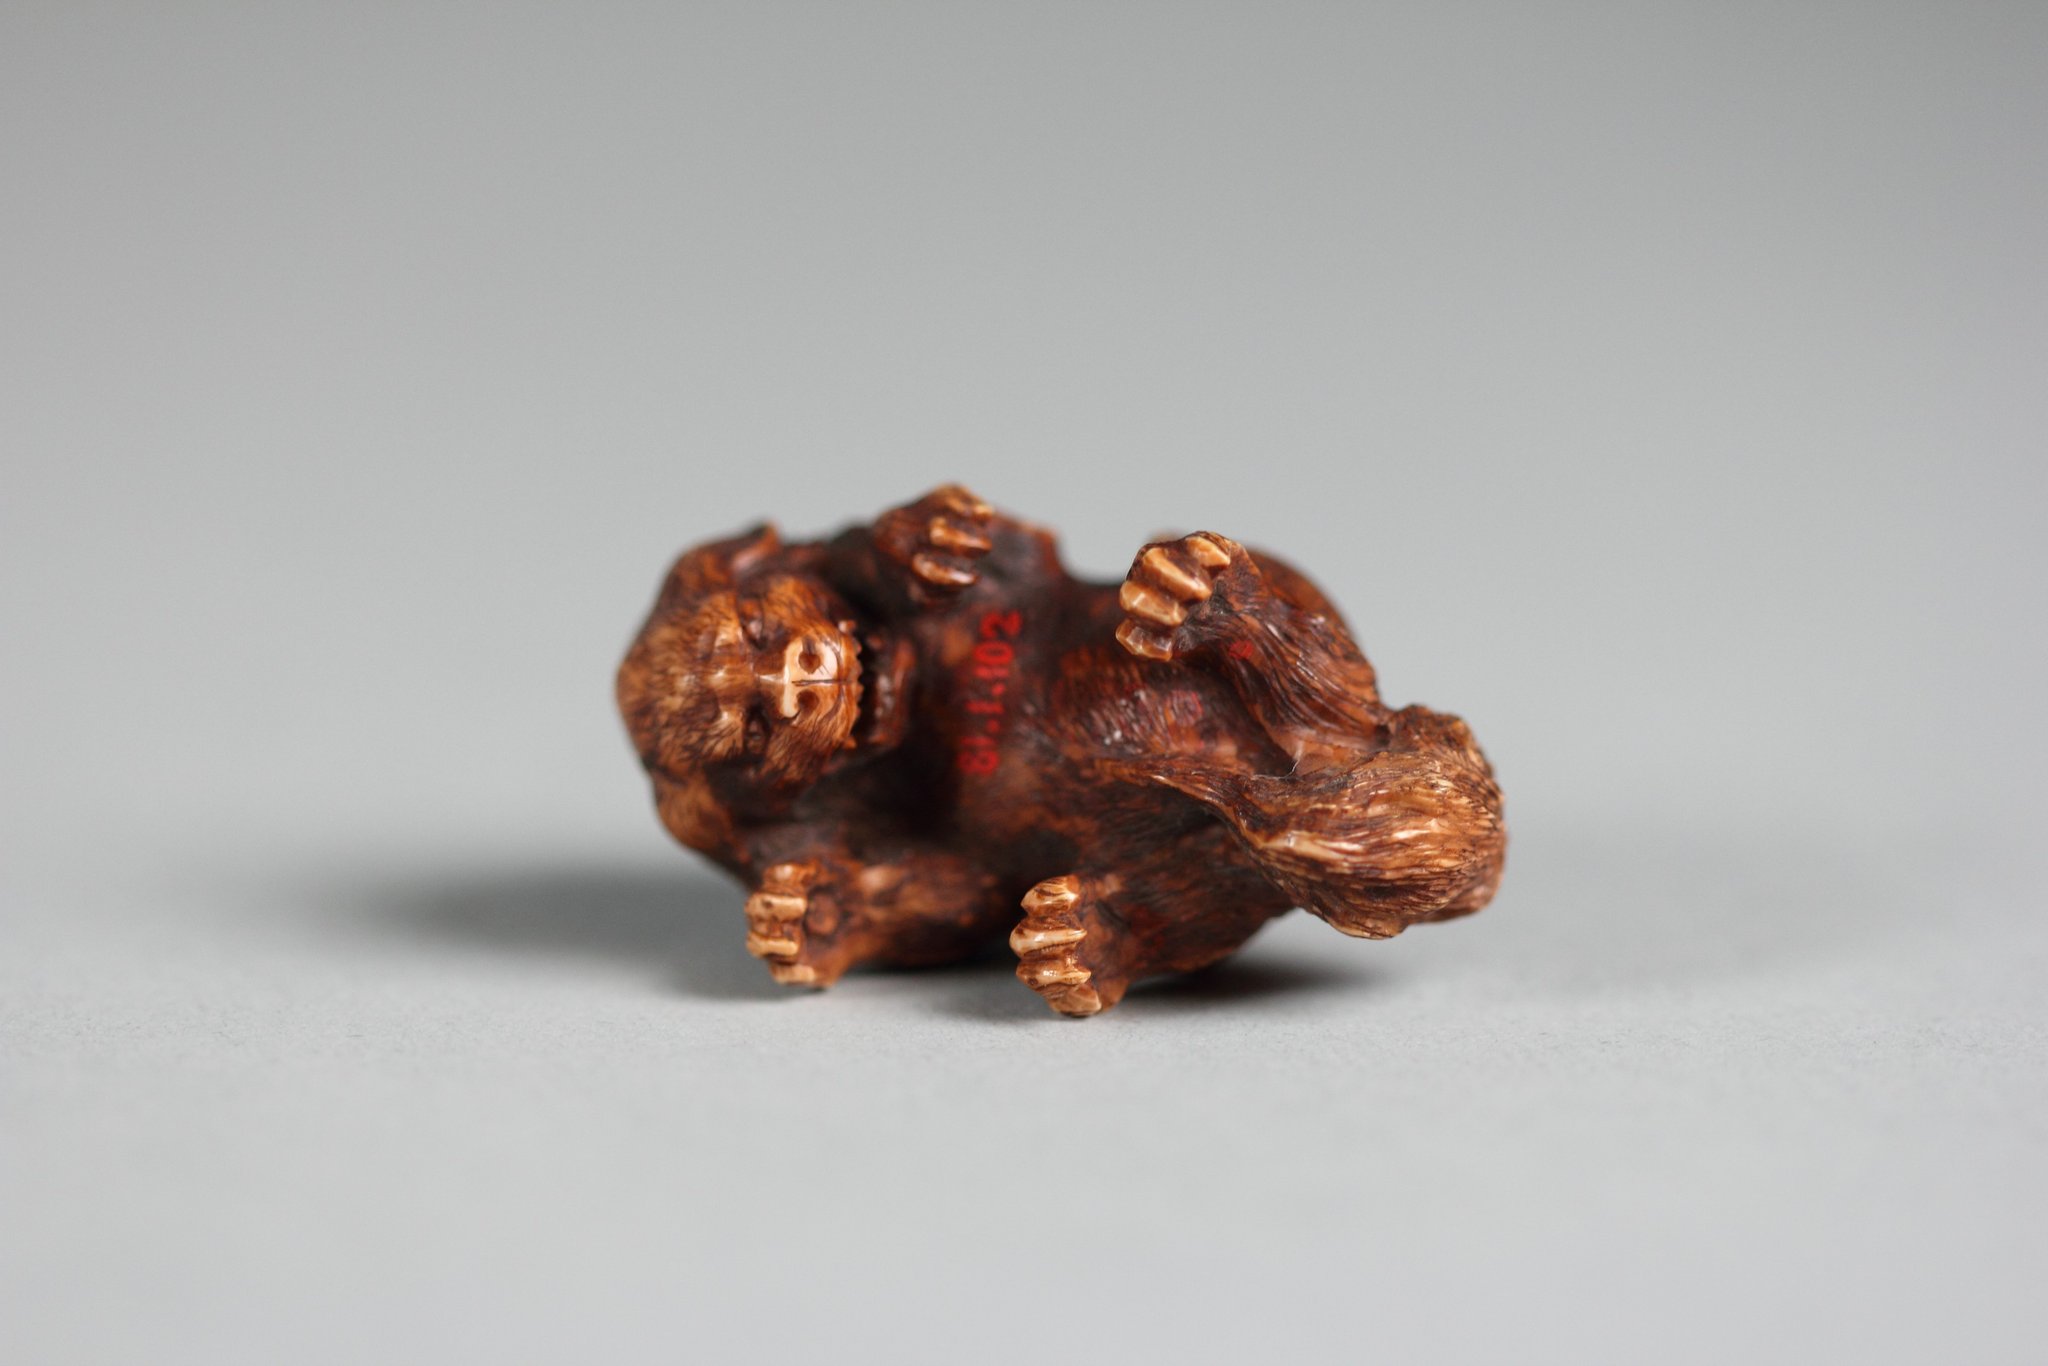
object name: netsuke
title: Lion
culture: japanese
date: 1801-1900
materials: ivory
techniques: stain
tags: lions